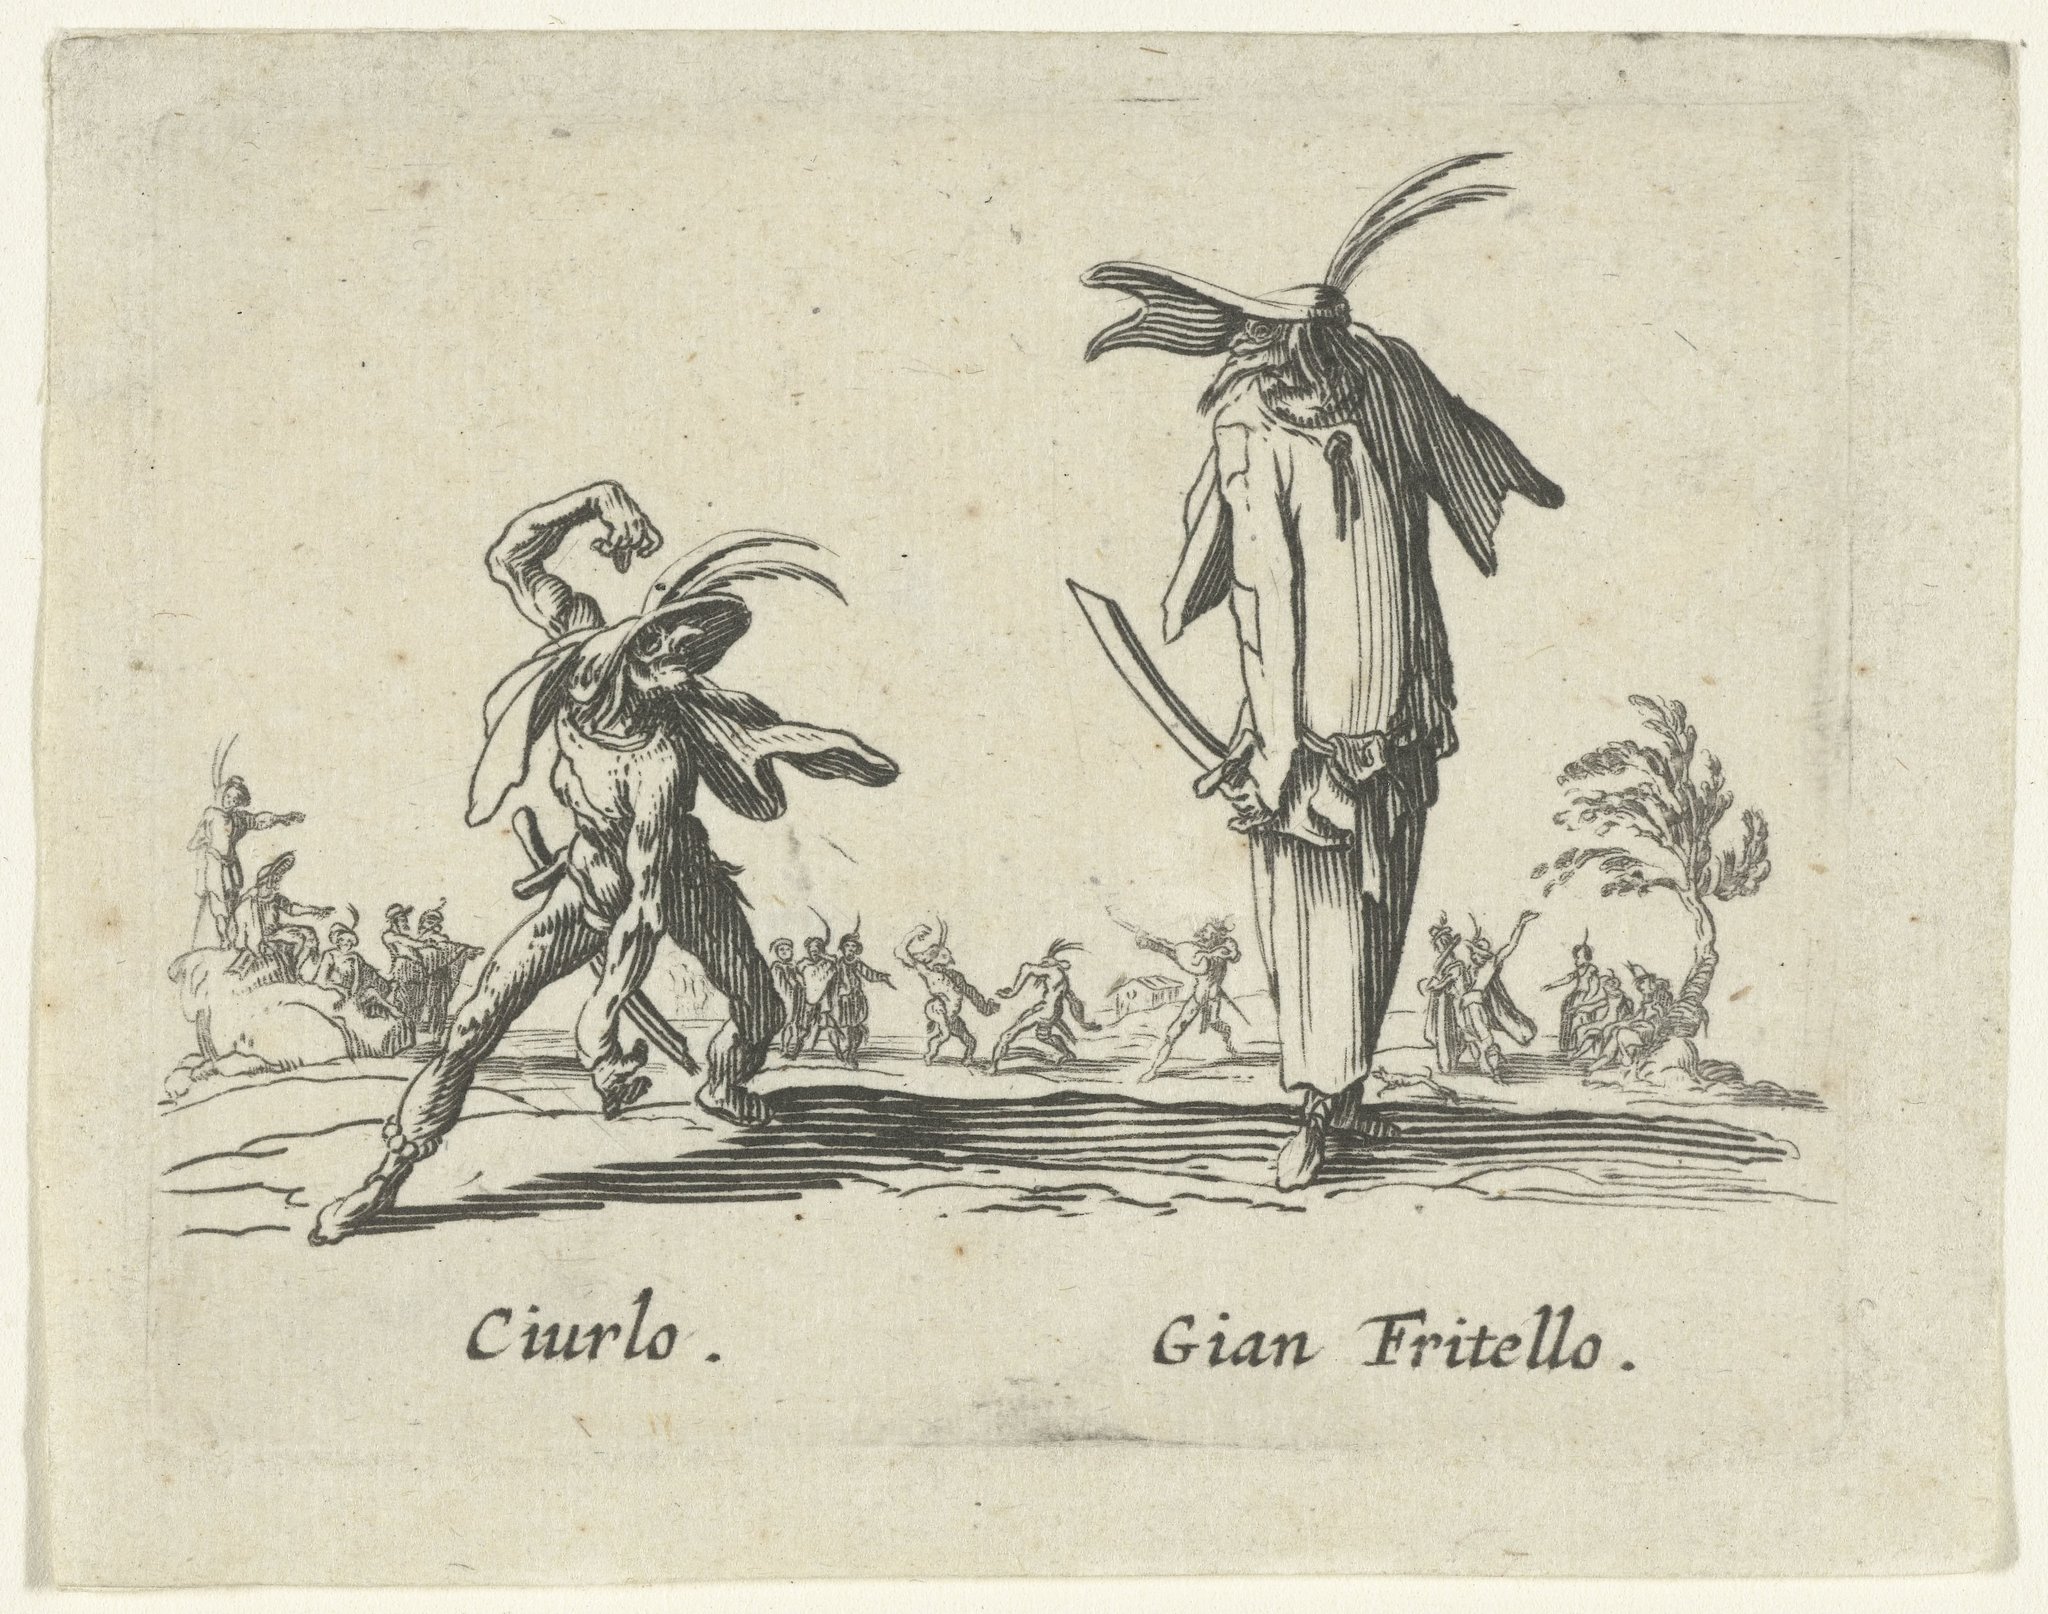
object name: print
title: Balli di Sfessania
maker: Anonymous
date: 1622-1670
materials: paper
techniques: etching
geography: low countries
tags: types in 'commedia dell'arte', dancing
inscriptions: collector's mark: Lugt 2228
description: Twee artiesten met gevederde hoofddeksels op, een van hen met een zwaard in de hand, dansen naast elkaar. Onder de figuren staan hun namen genoteerd. Deze prent is onderdeel van een serie van 23 prenten (24 incl. titelprent) met telkens op de voorgrond twee straatartiesten verkleed als figuren uit de Italiaanse commedia dell'arte, en op de achtergrond toeschouwers die in de buitenlucht een (dans)voorstelling van straatartiesten gadeslaan.